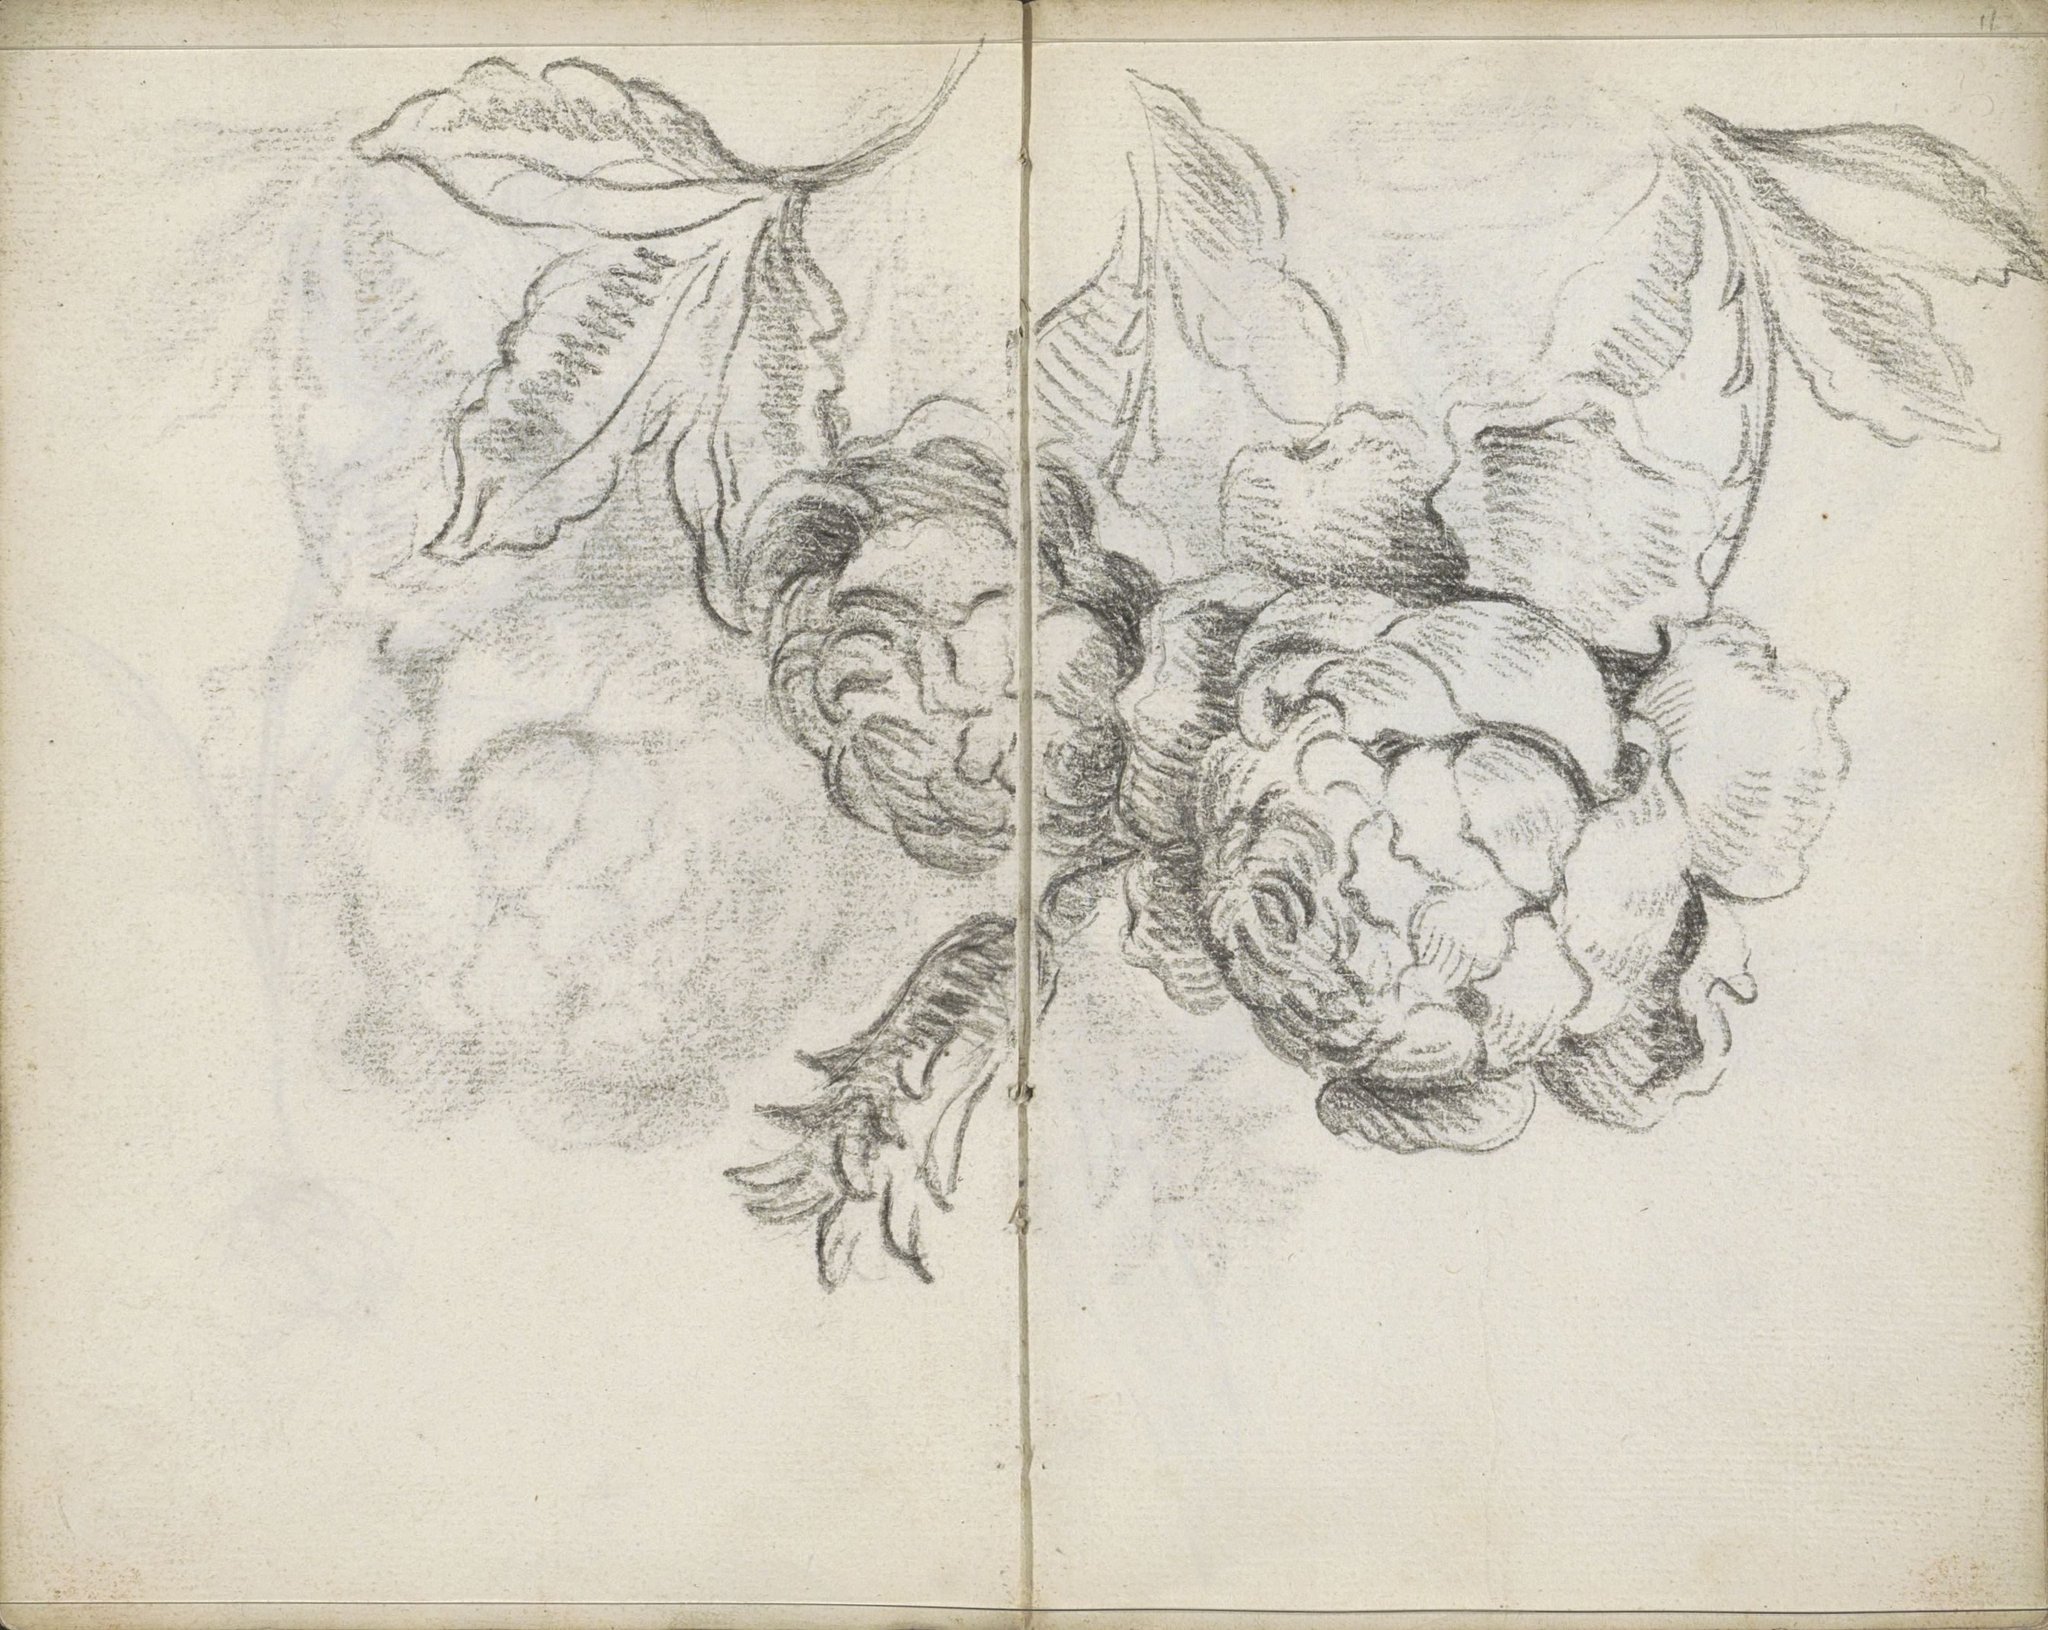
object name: sketchbook leaf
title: Flowers and Leaves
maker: petrus johannes van reysschoot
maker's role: draughtsman, print maker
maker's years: 1702-1772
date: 1710-1772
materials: chalk, paper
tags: flowers, flowers (+ leaf)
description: Verso van een ongenummerd blad tussen blad 10 en 11 en blad 11 recto uit een schetsboek met 105 bladen.